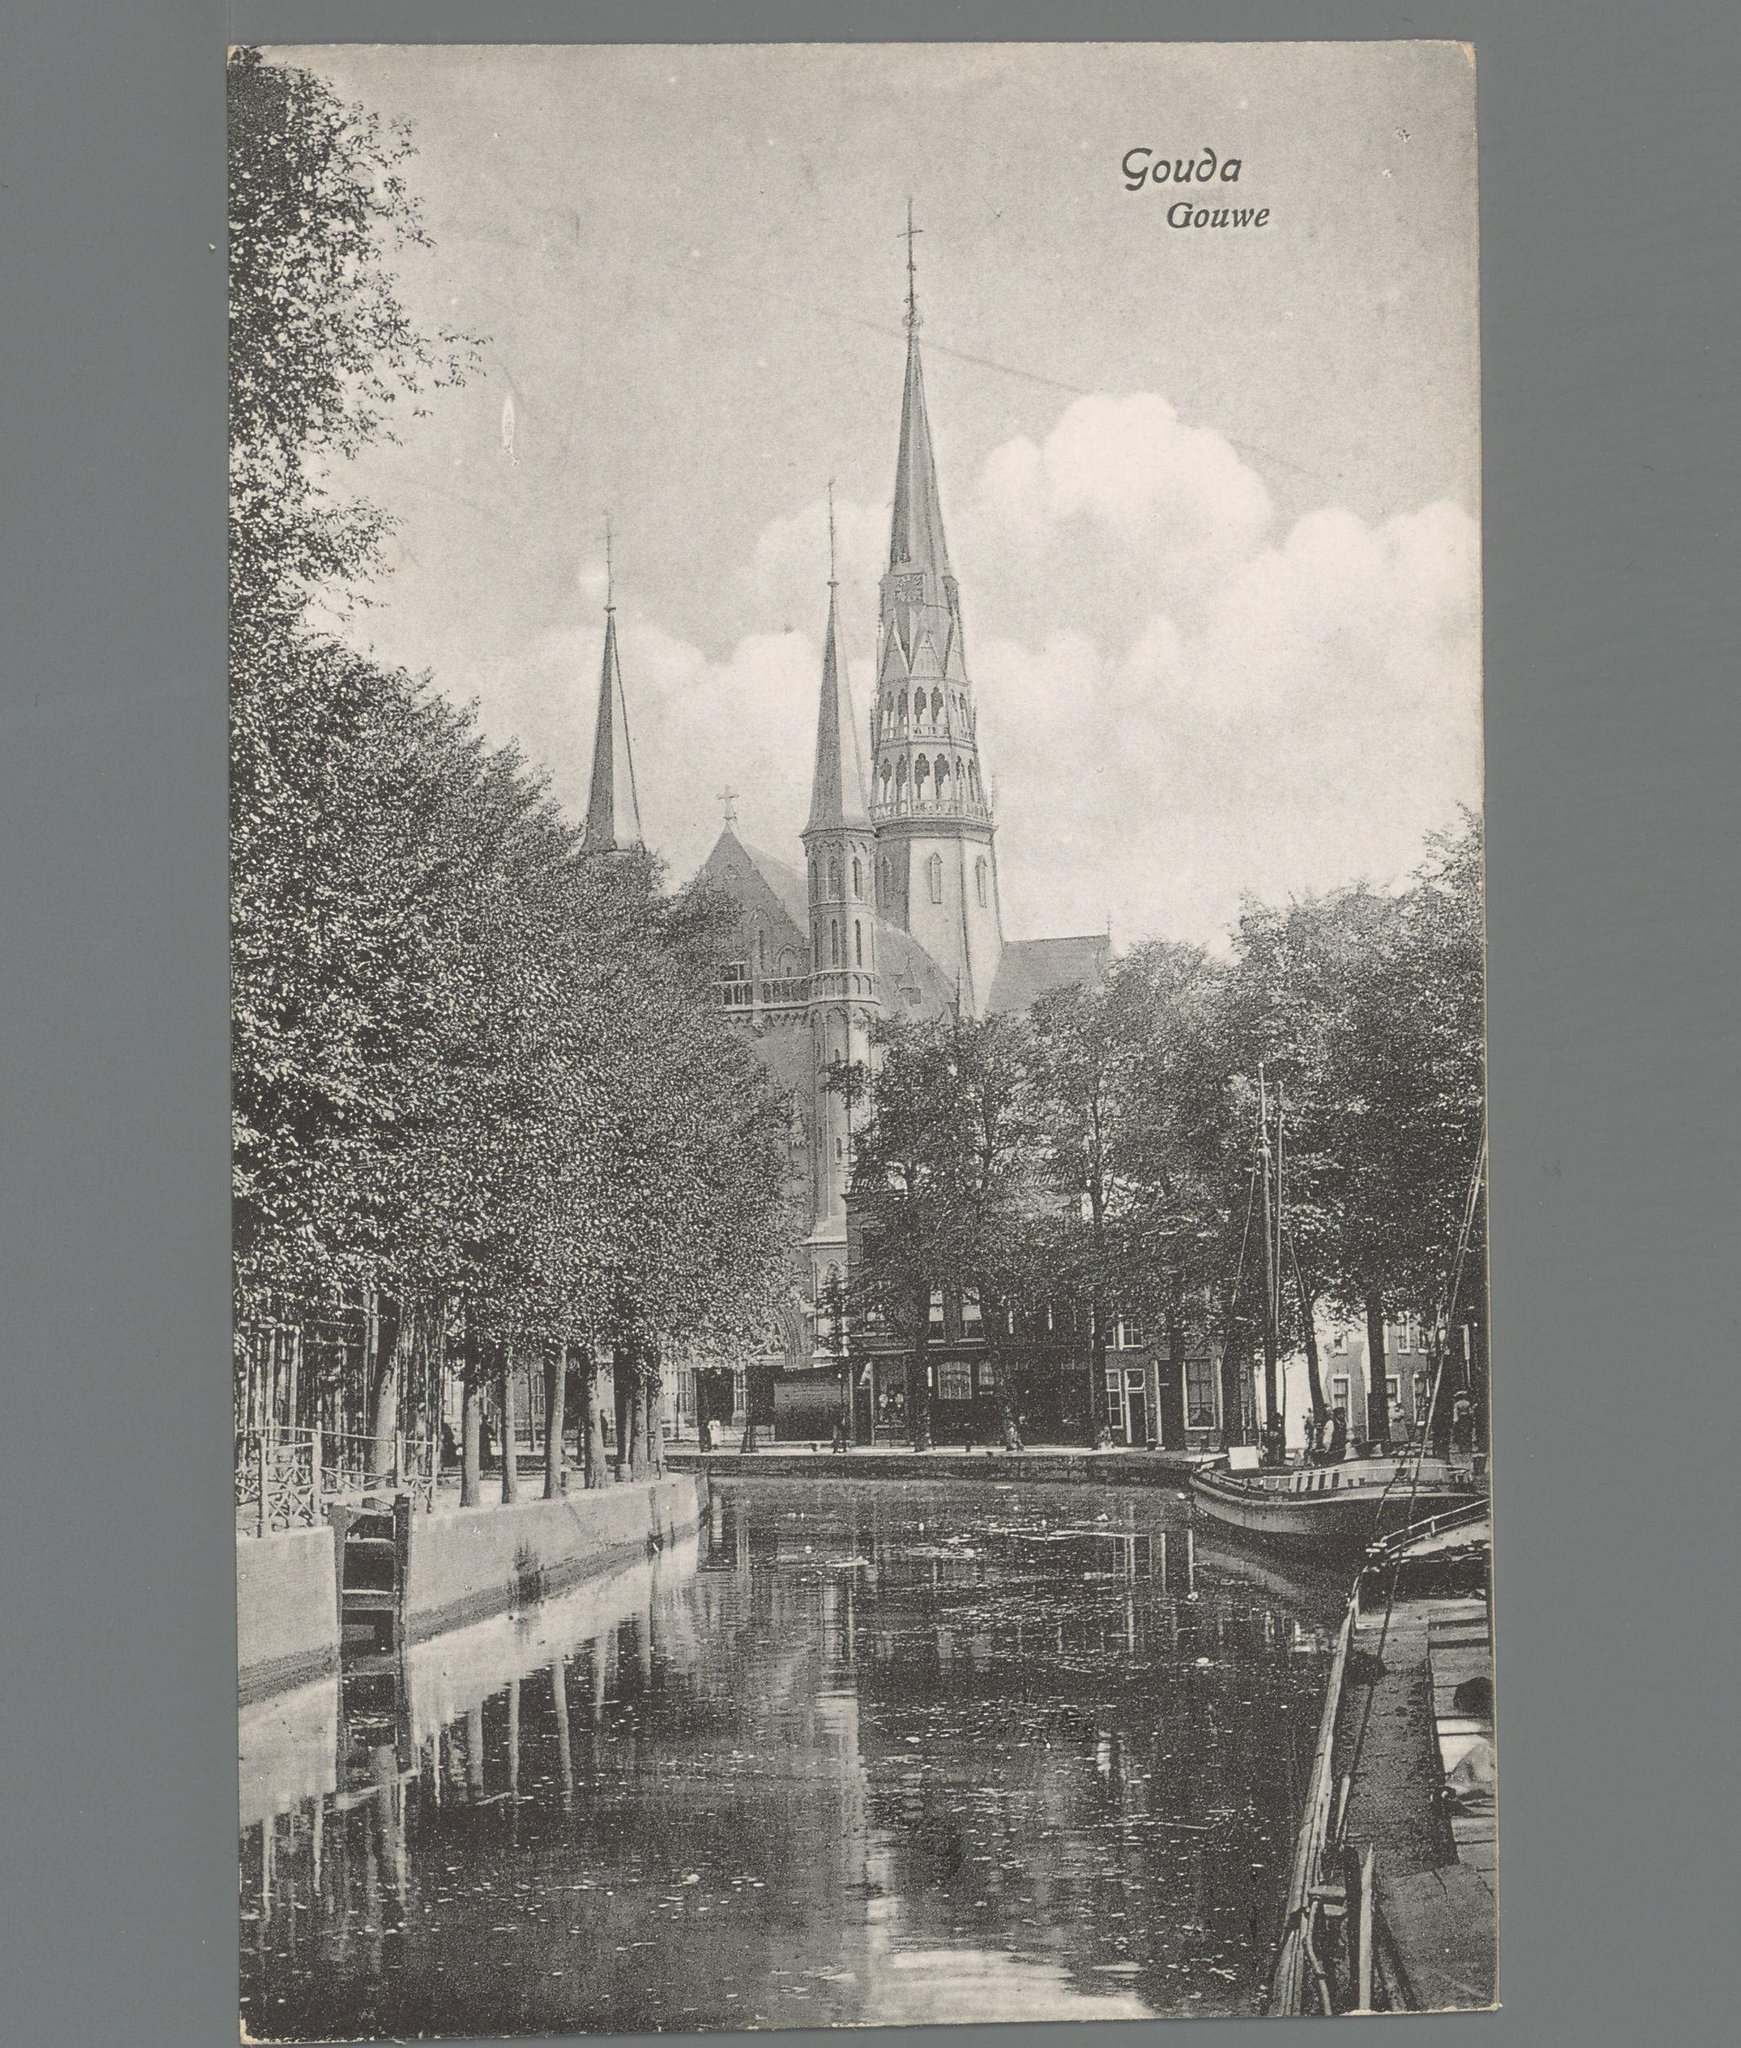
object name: ansichtkaart, prentbriefkaart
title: Gouda. Gouwe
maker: Anonymous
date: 1908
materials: cardboard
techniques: photograph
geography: gouda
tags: canal, church (exterior)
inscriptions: date